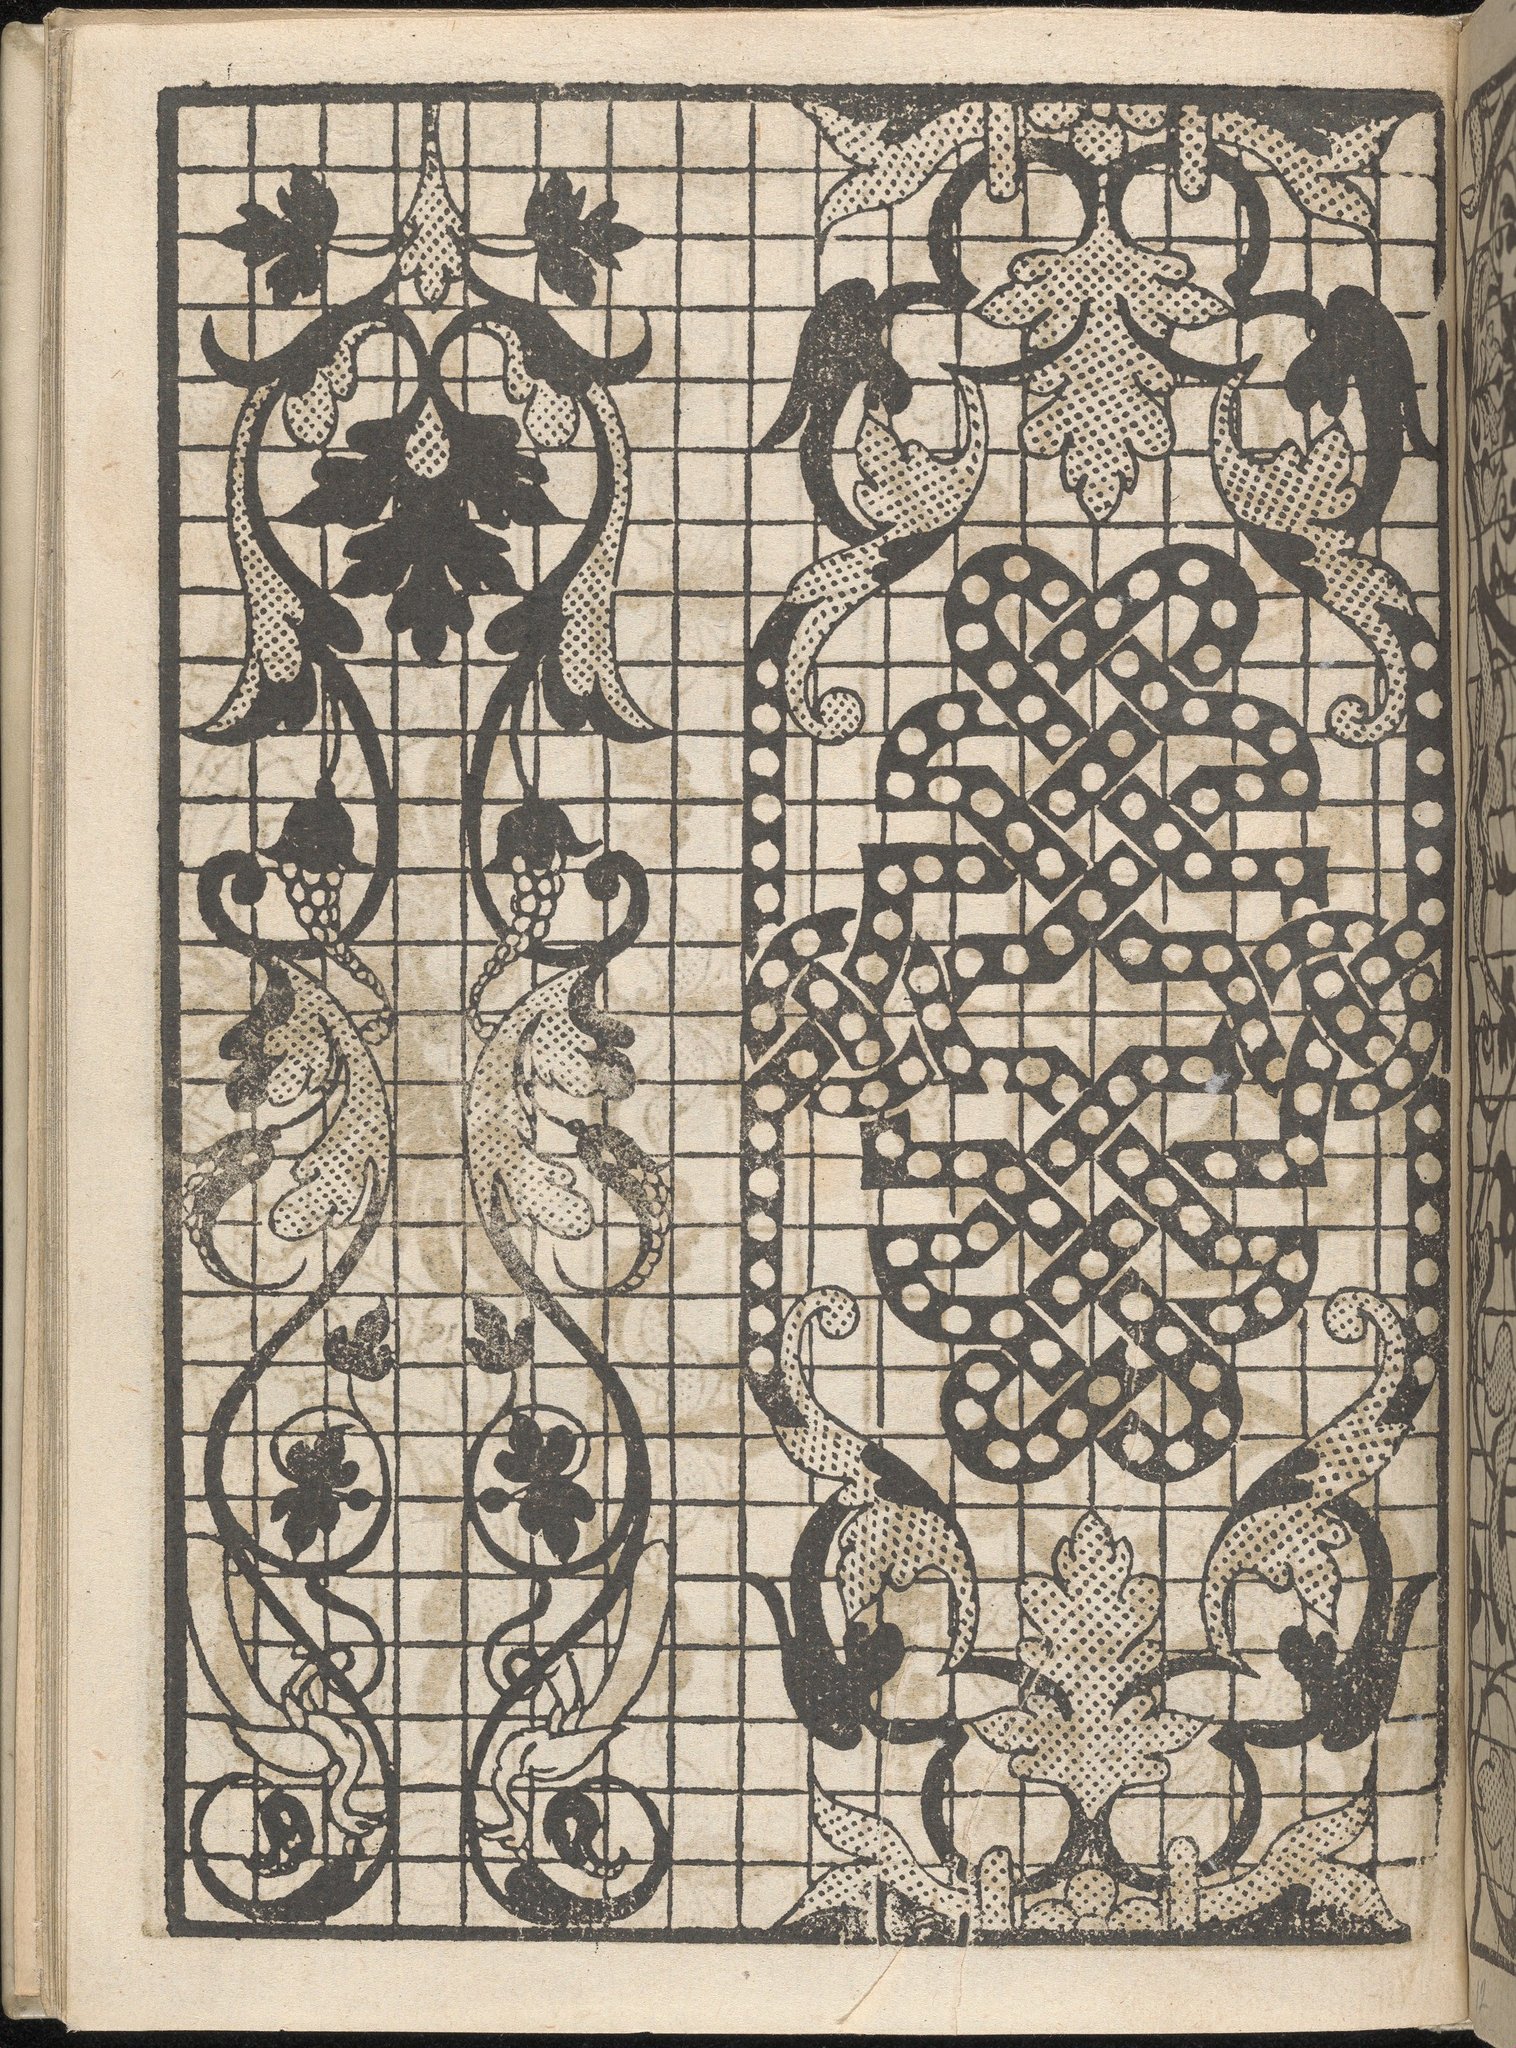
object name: book print ornament architecture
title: Splendore delle virtuose giovani, page 11 (verso)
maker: iseppo foresto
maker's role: designer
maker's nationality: italian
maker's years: 1520-1580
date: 1564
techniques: woodcut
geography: italy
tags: grapes,peacocks,flowers,leaves